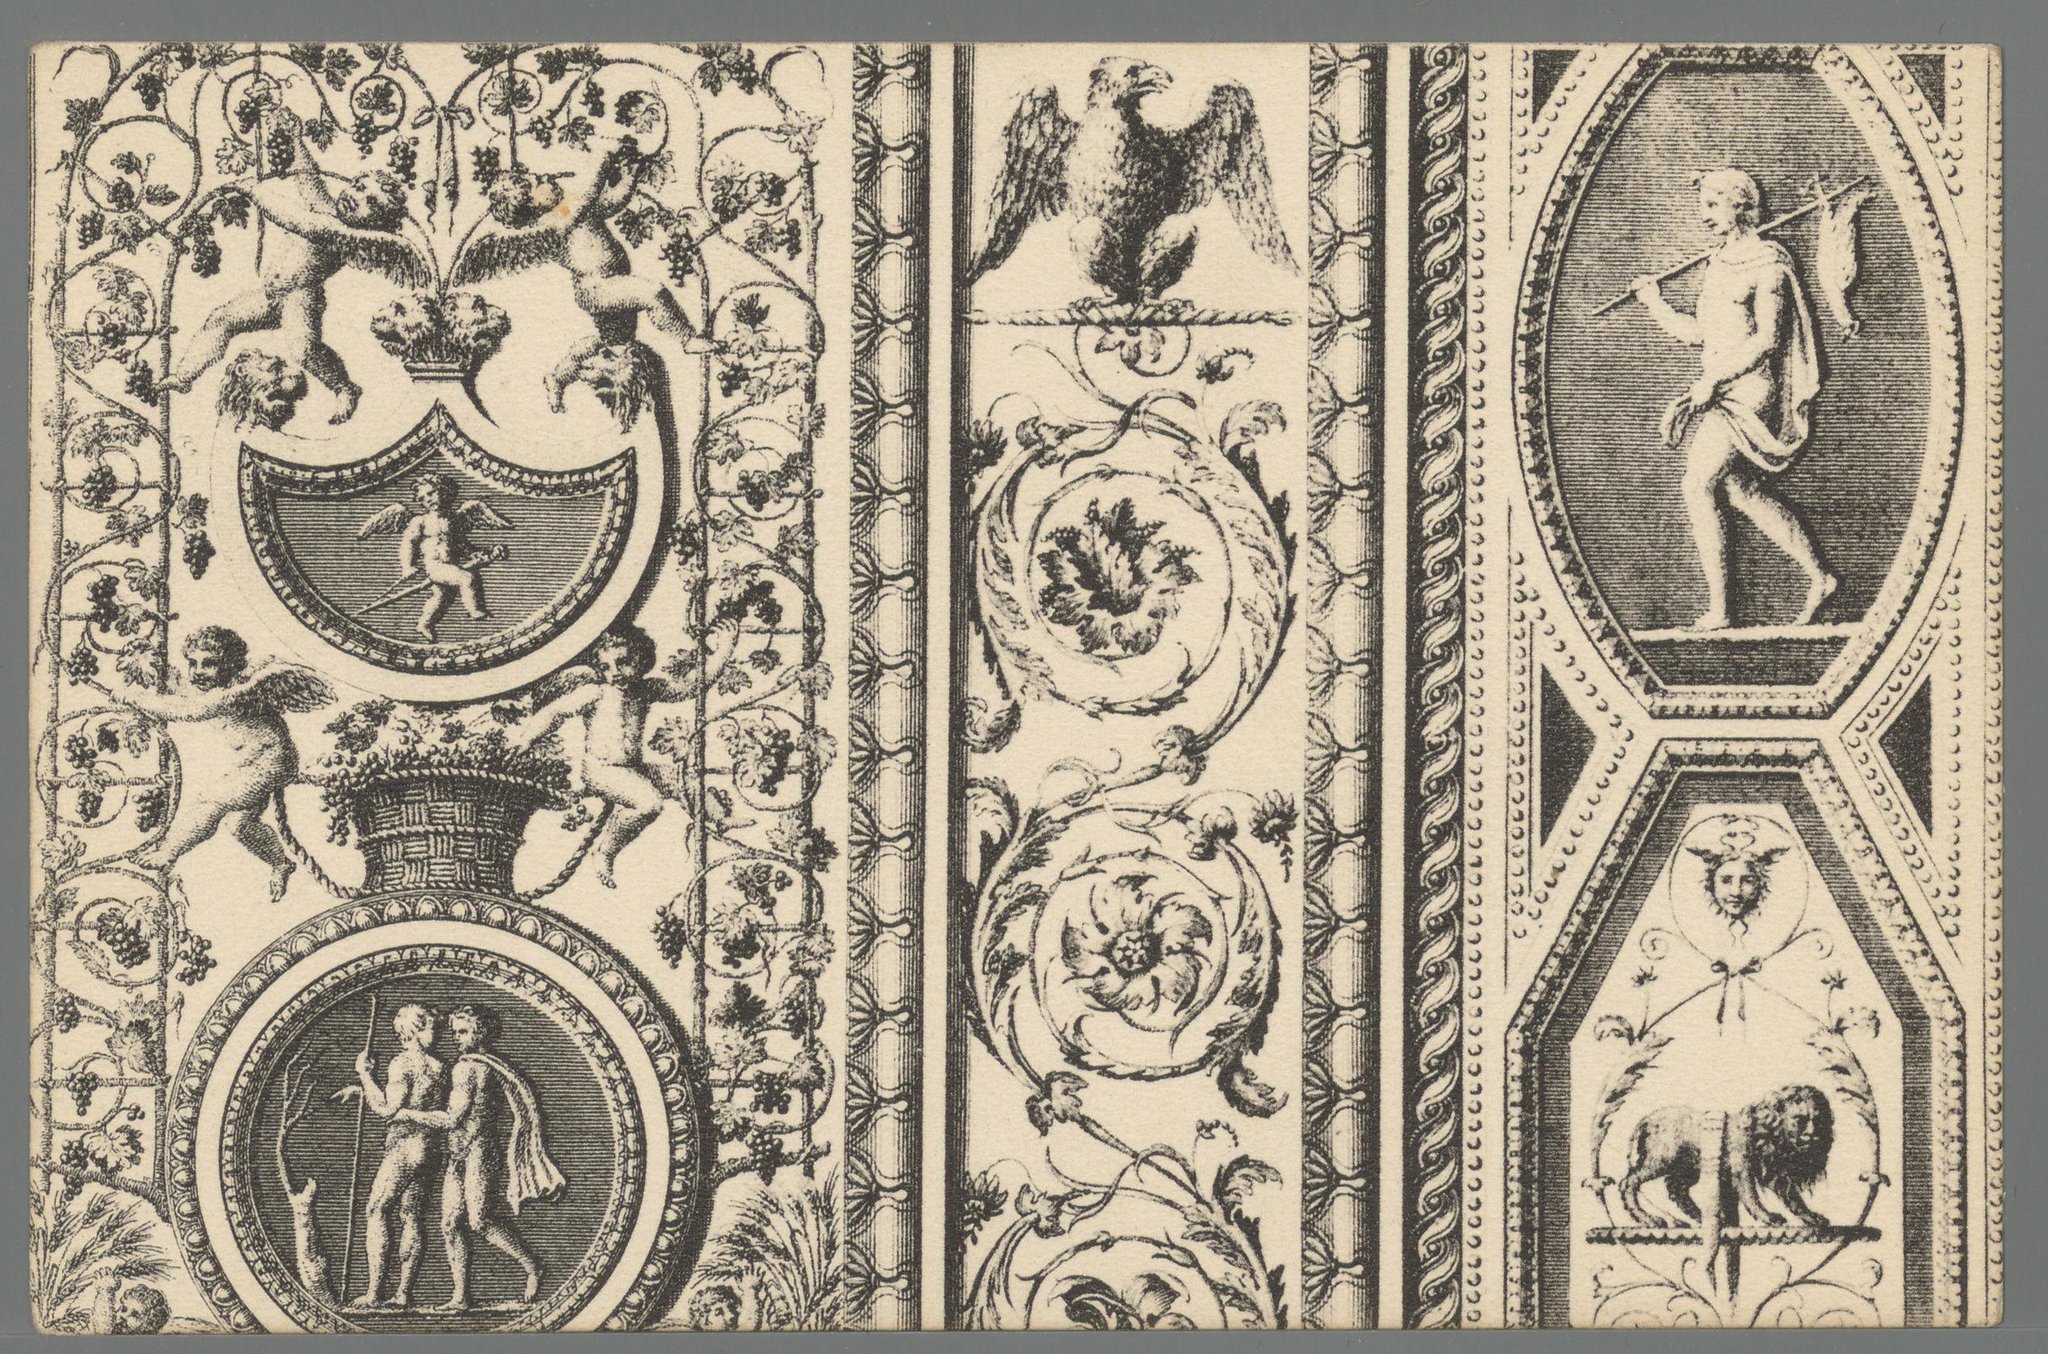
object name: ansichtkaart, prentbriefkaart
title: Roma. Loggie di Raffaello Sanzio nel Vaticano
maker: Anonymous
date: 1906-1920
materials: cardboard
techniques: photograph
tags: palace - aa - civic architecture: inside, decorations (interior of the house), picture, painting